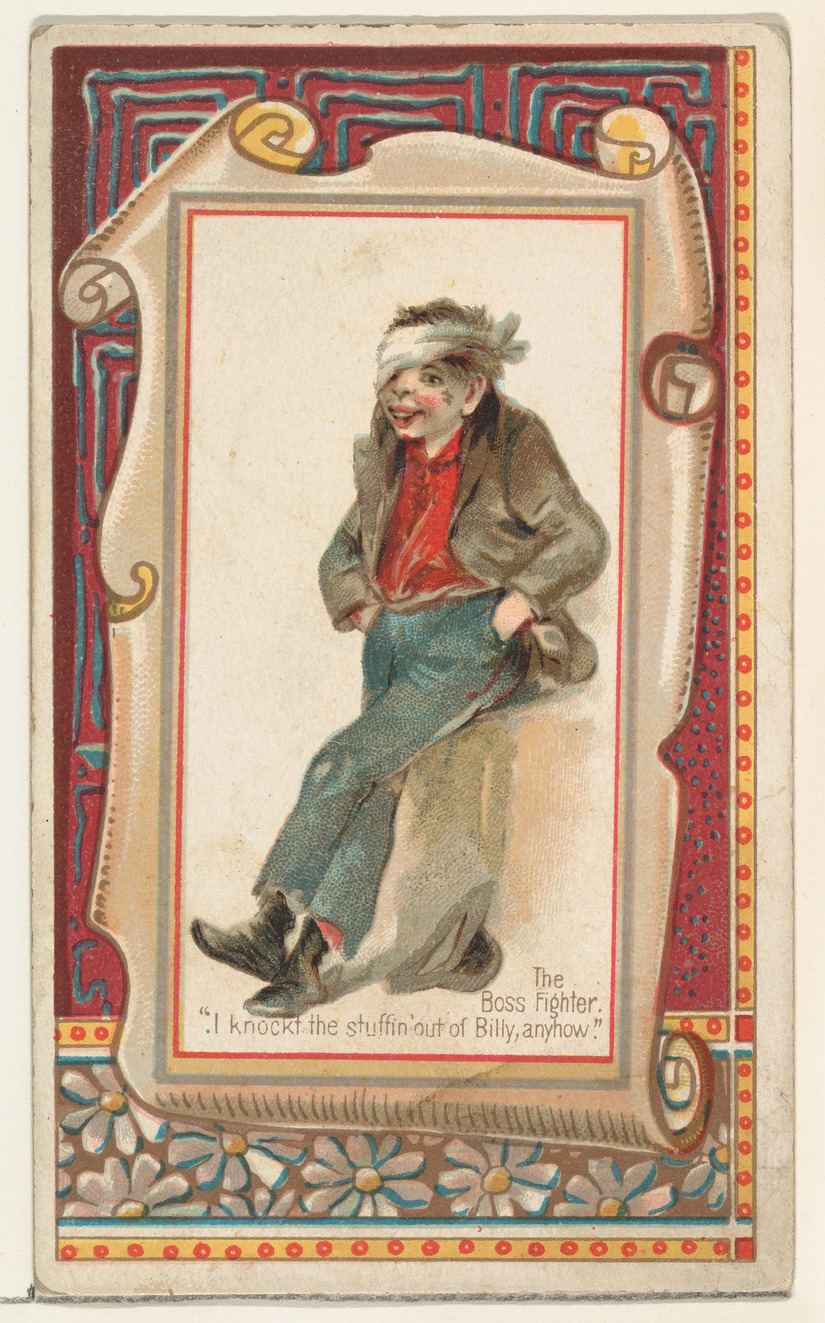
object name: print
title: The Boss Fighter, "I knockt the stuffin' out of Billy, anyhow," from the Terrors of America set (N136) issued by Duke Sons & Co. to promote Honest Long Cut Tobacco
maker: w. duke, sons & co.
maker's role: publisher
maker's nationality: american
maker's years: 1870-1920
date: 1888-1889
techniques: color lithograph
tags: boys